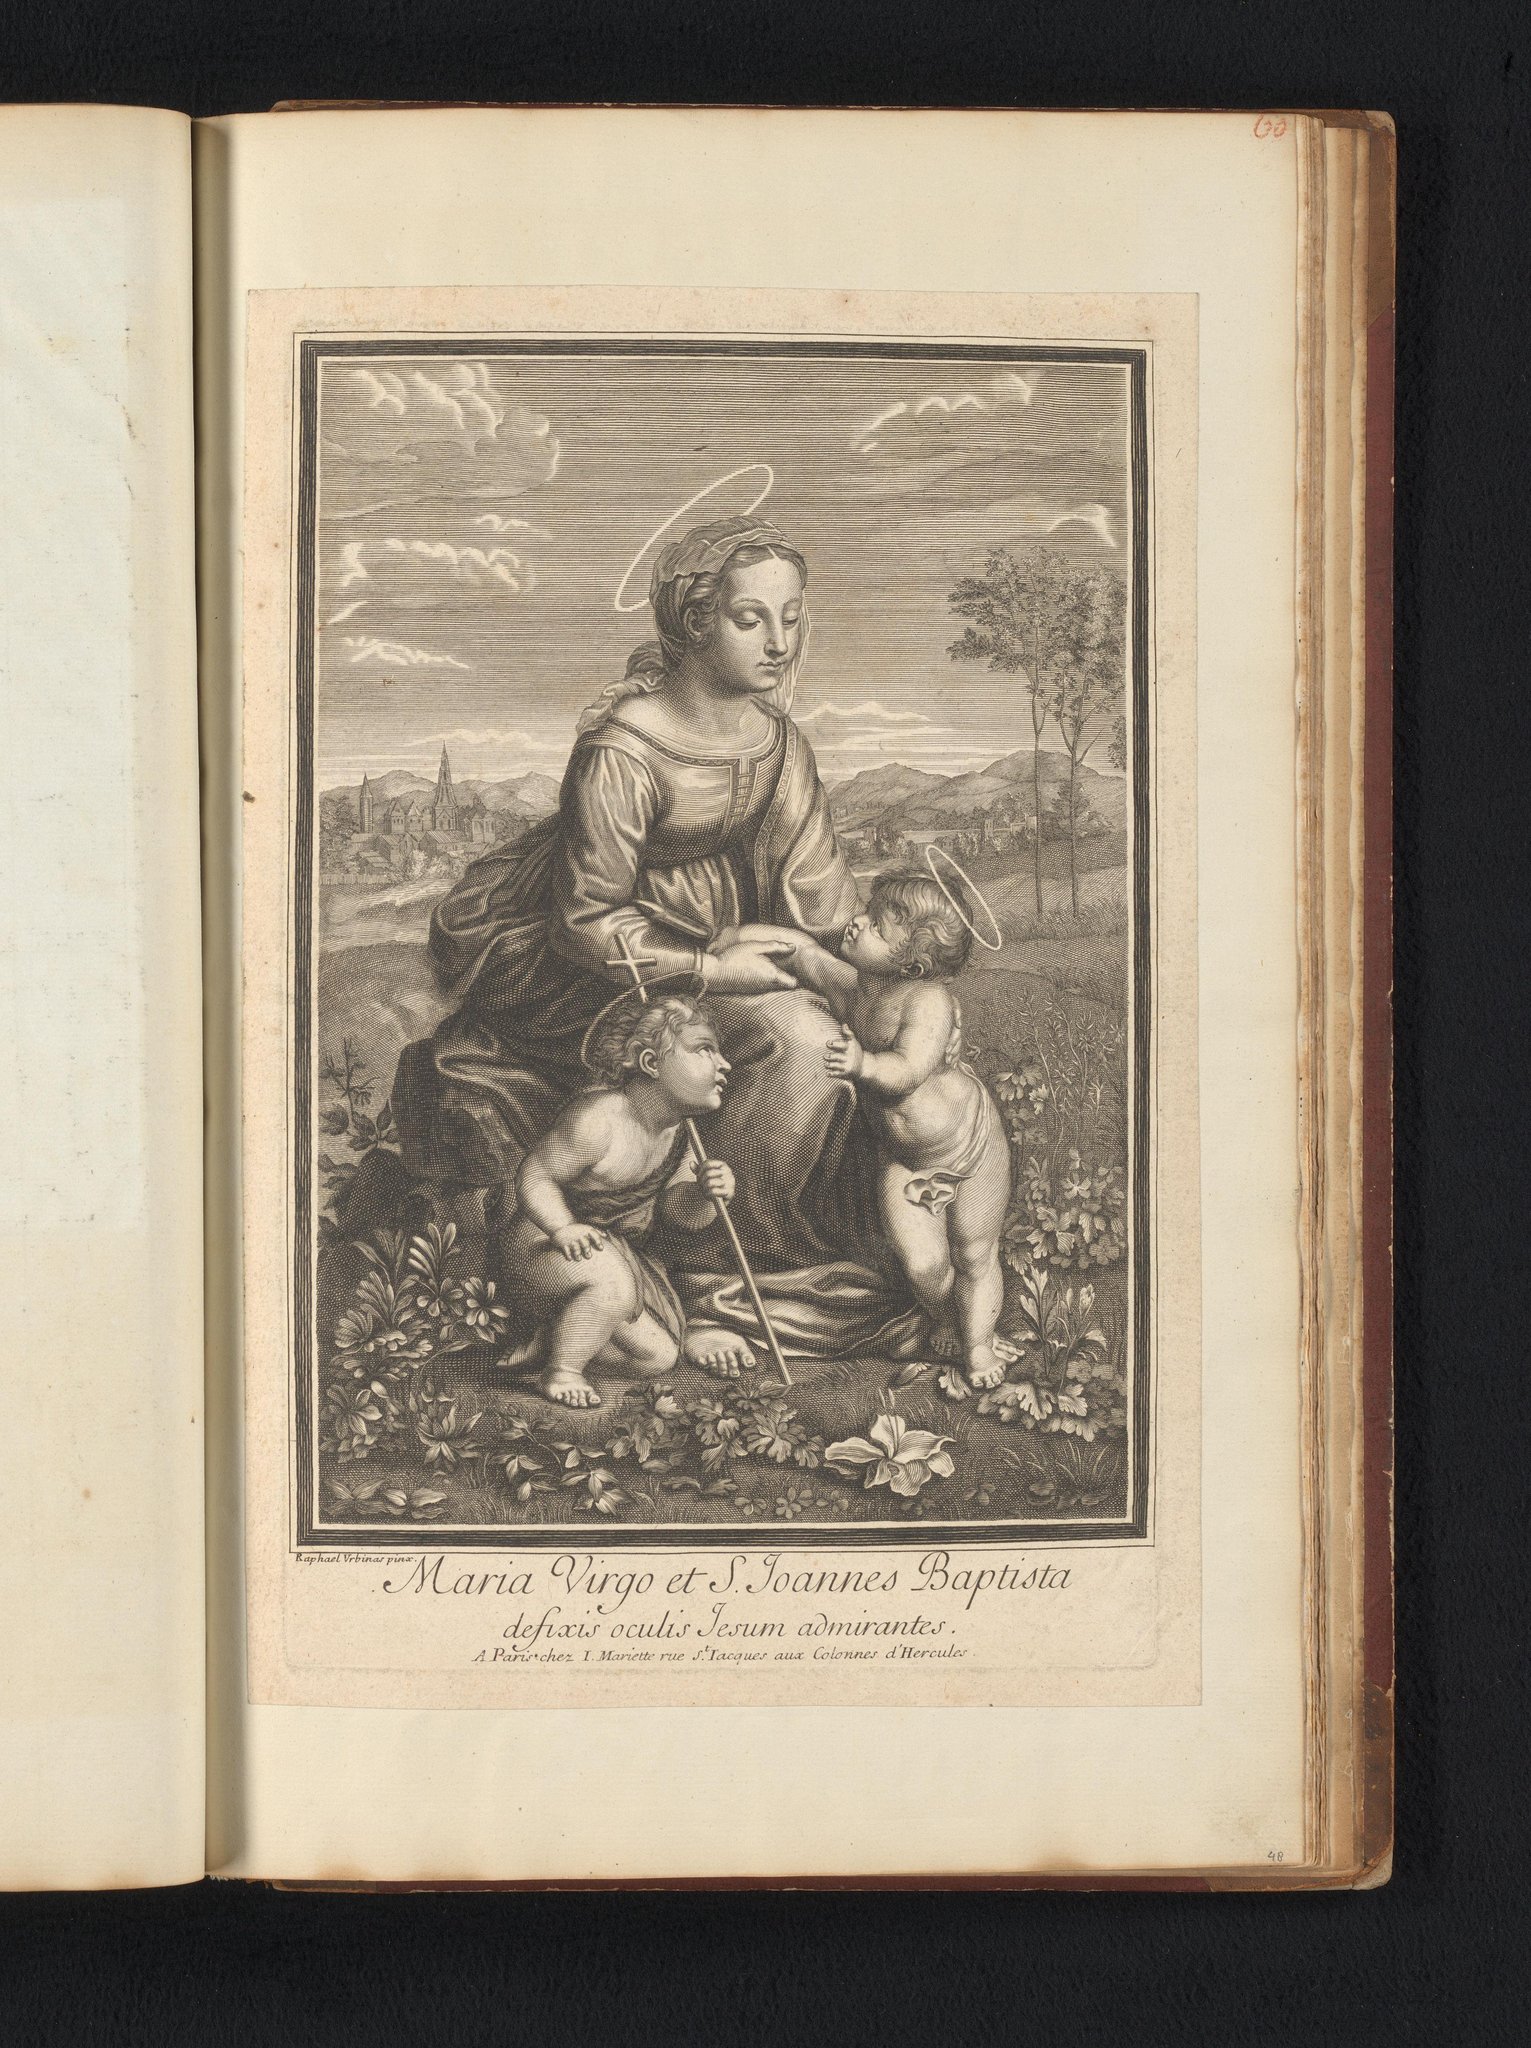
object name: album leaf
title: Madonna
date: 1690-1742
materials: paper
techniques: engraving, etching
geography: paris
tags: mary and the christ-child with john the baptist (as child)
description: Ingeplakte prent naar schilderij van Maria met kind en Johannes de Doper. Onderdeel van het tweede van twee albums met ingeplakte prenten en tekeningen te dienen als tekenvoorbeelden.